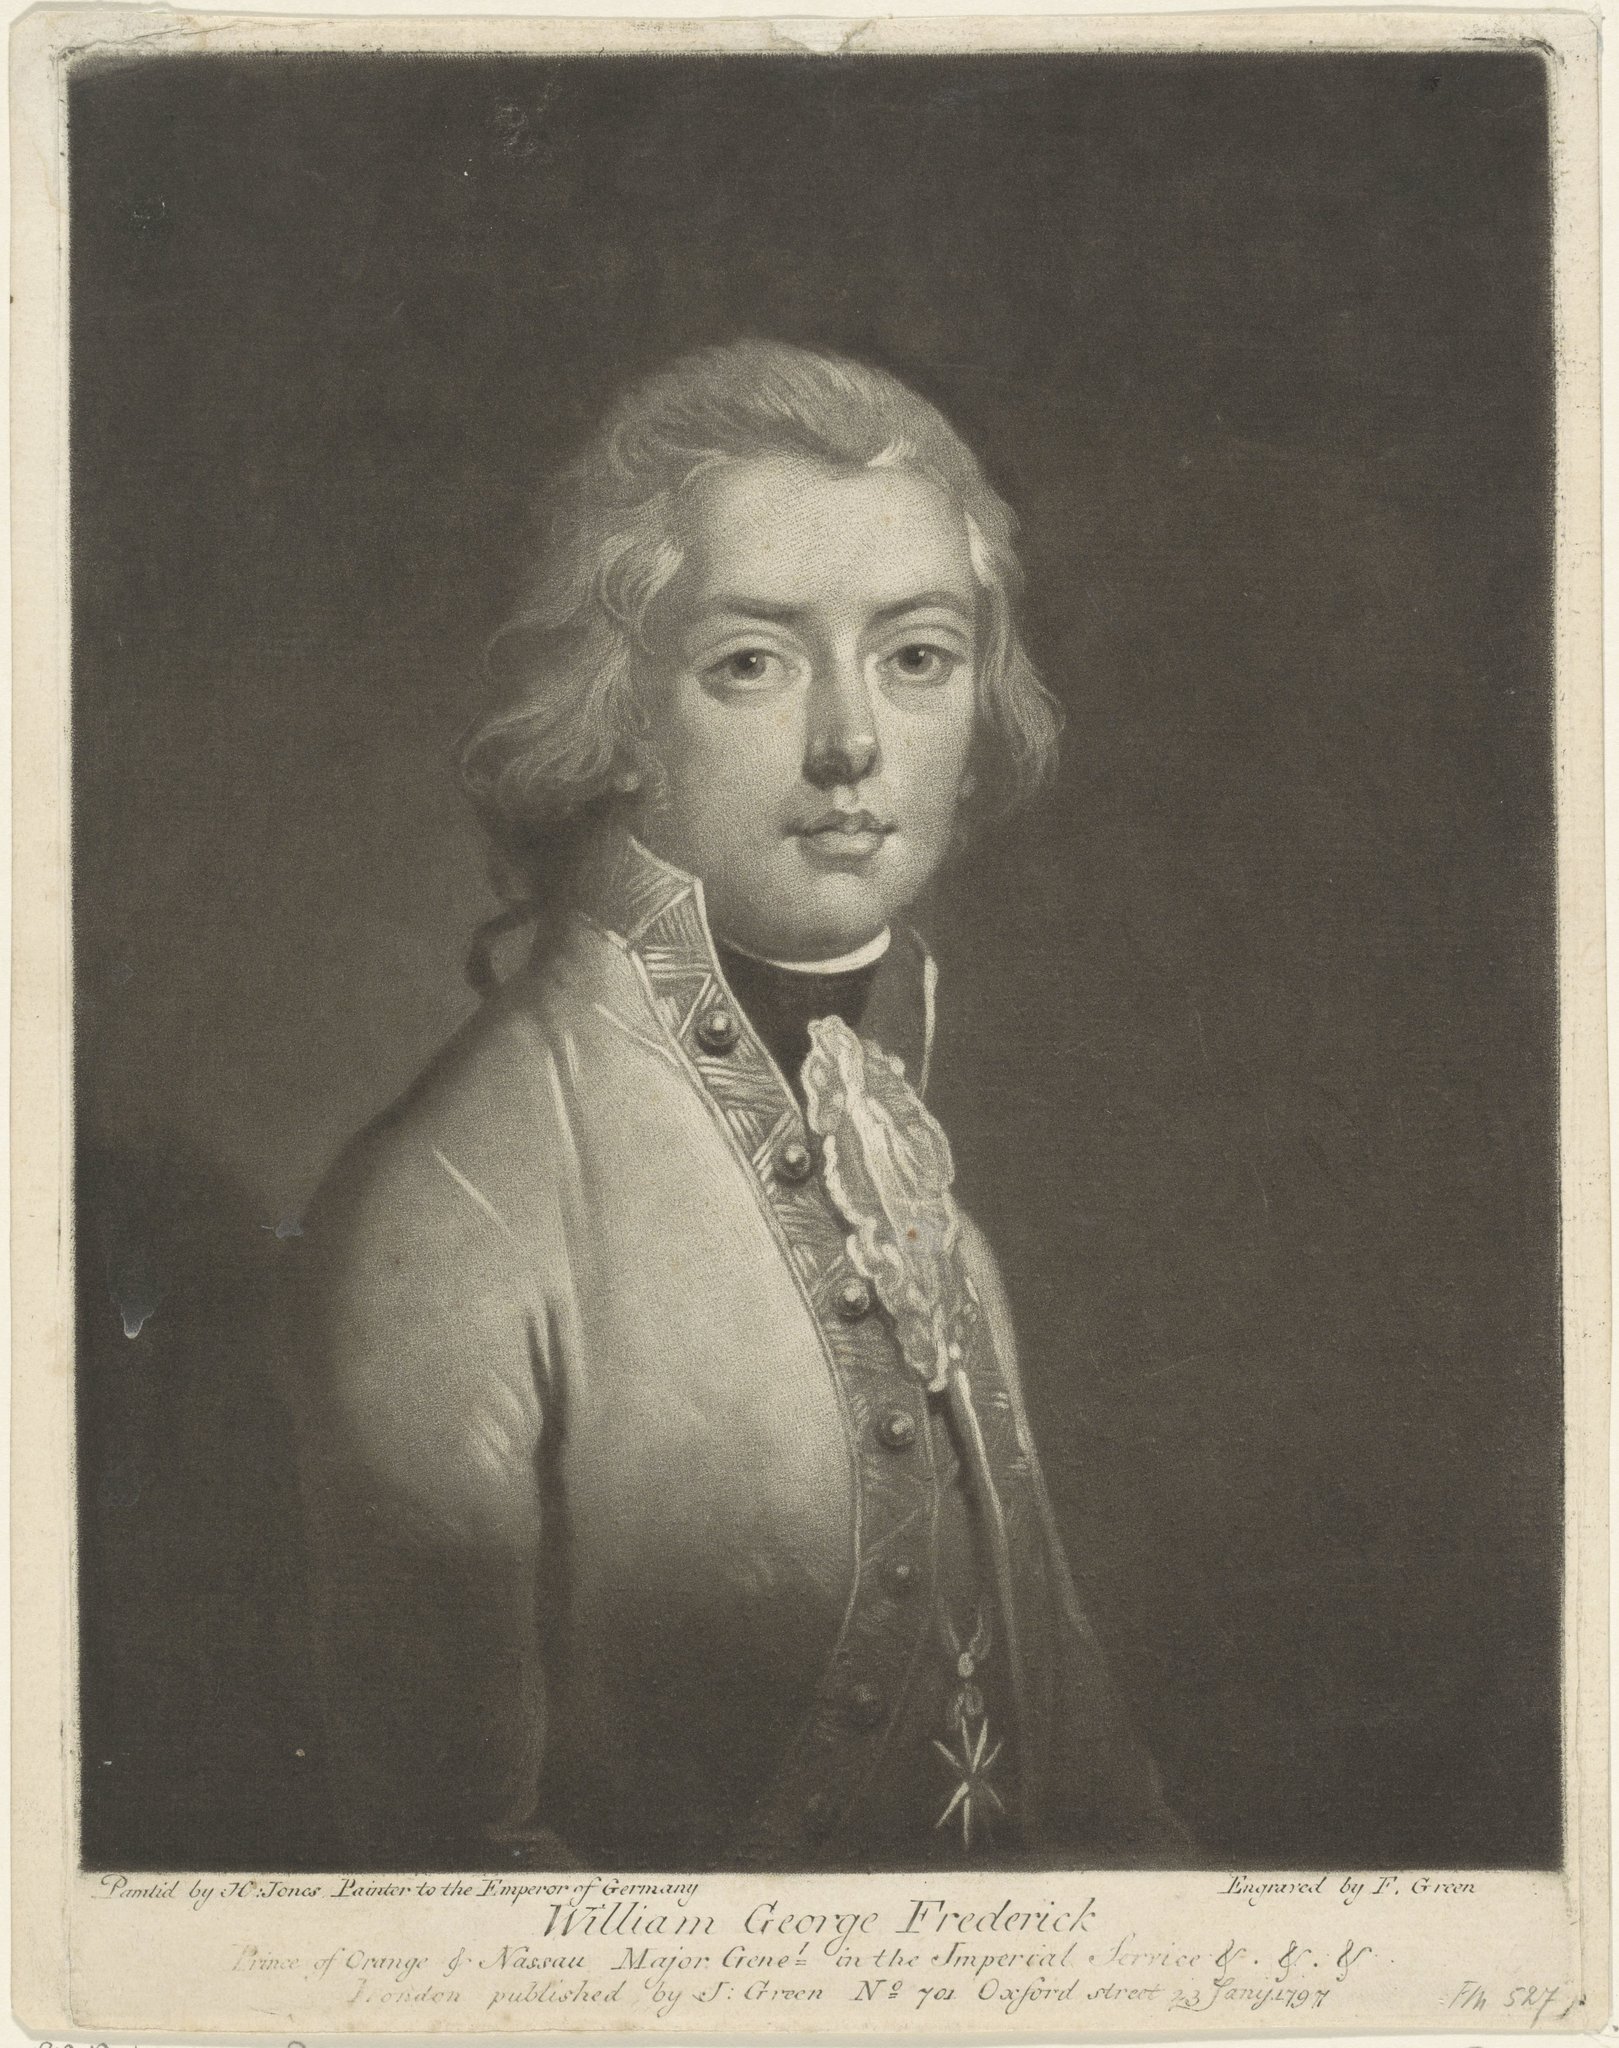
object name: print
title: Portret van Frederik, prins van Oranje-Nassau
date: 1797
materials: paper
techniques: mezzotint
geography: london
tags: the hague, willem george frederik (prins van oranje-nassau)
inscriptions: collector's mark: Lugt 2228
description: De hier vermelde titel verwijst naar de hoogst verkregen titel van de geportretteerde, niet per se naar de titel die de geportretteerde op deze voorstelling draagt.